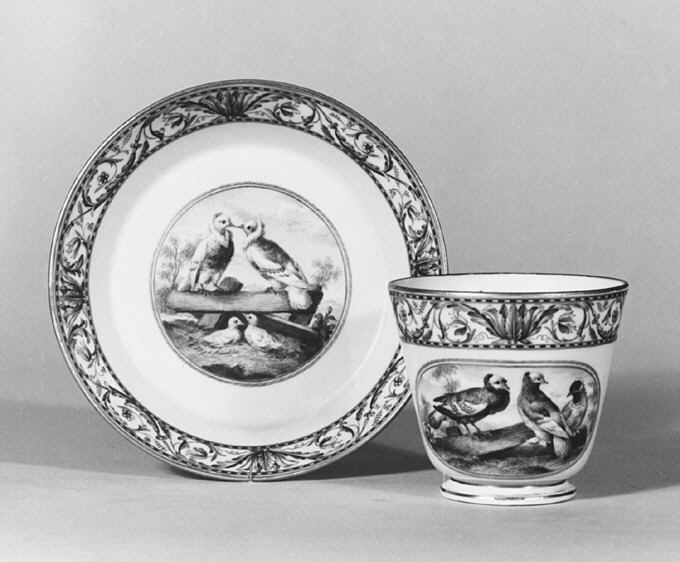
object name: saucer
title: Saucer (part of a service)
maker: meissen manufactory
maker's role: manufactory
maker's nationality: german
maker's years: 1710-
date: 1780-1785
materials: hard paste porcelain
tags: birds